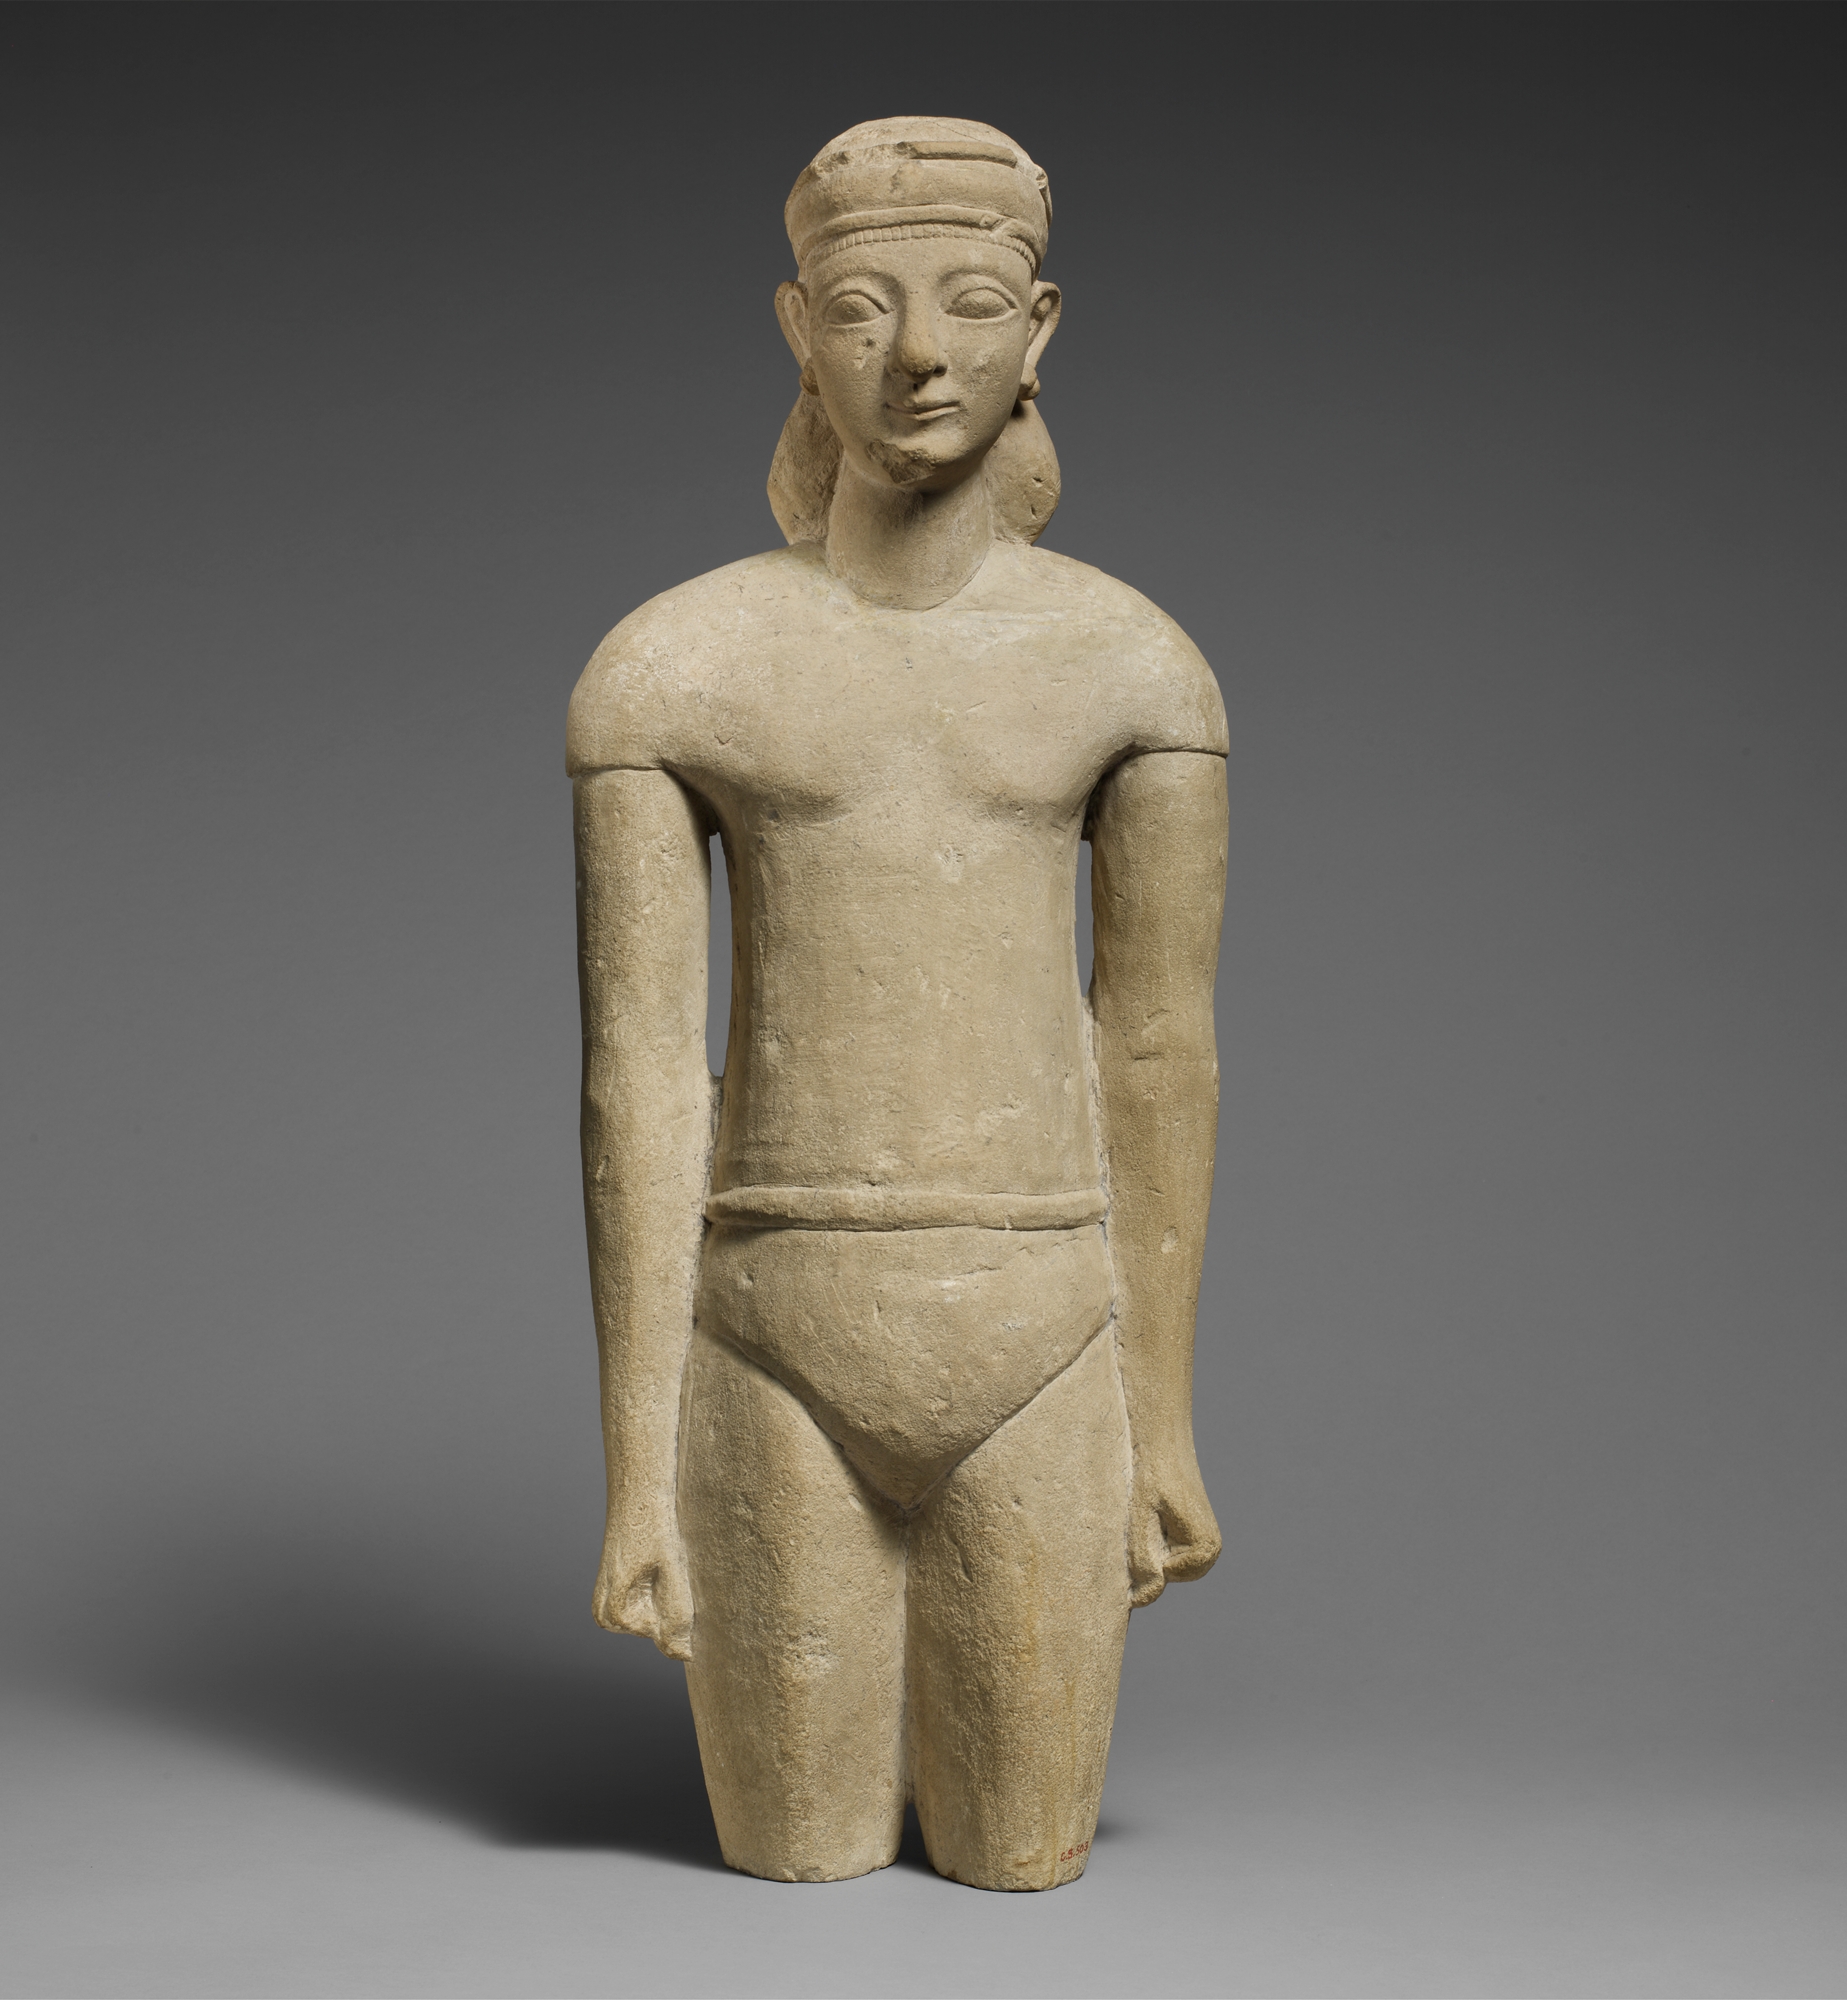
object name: statue of a votary, male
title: Limestone statuette of a male votary with Cypriot shorts and a diadem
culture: cypriot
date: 600-568 BCE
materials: limestone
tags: diadems,men